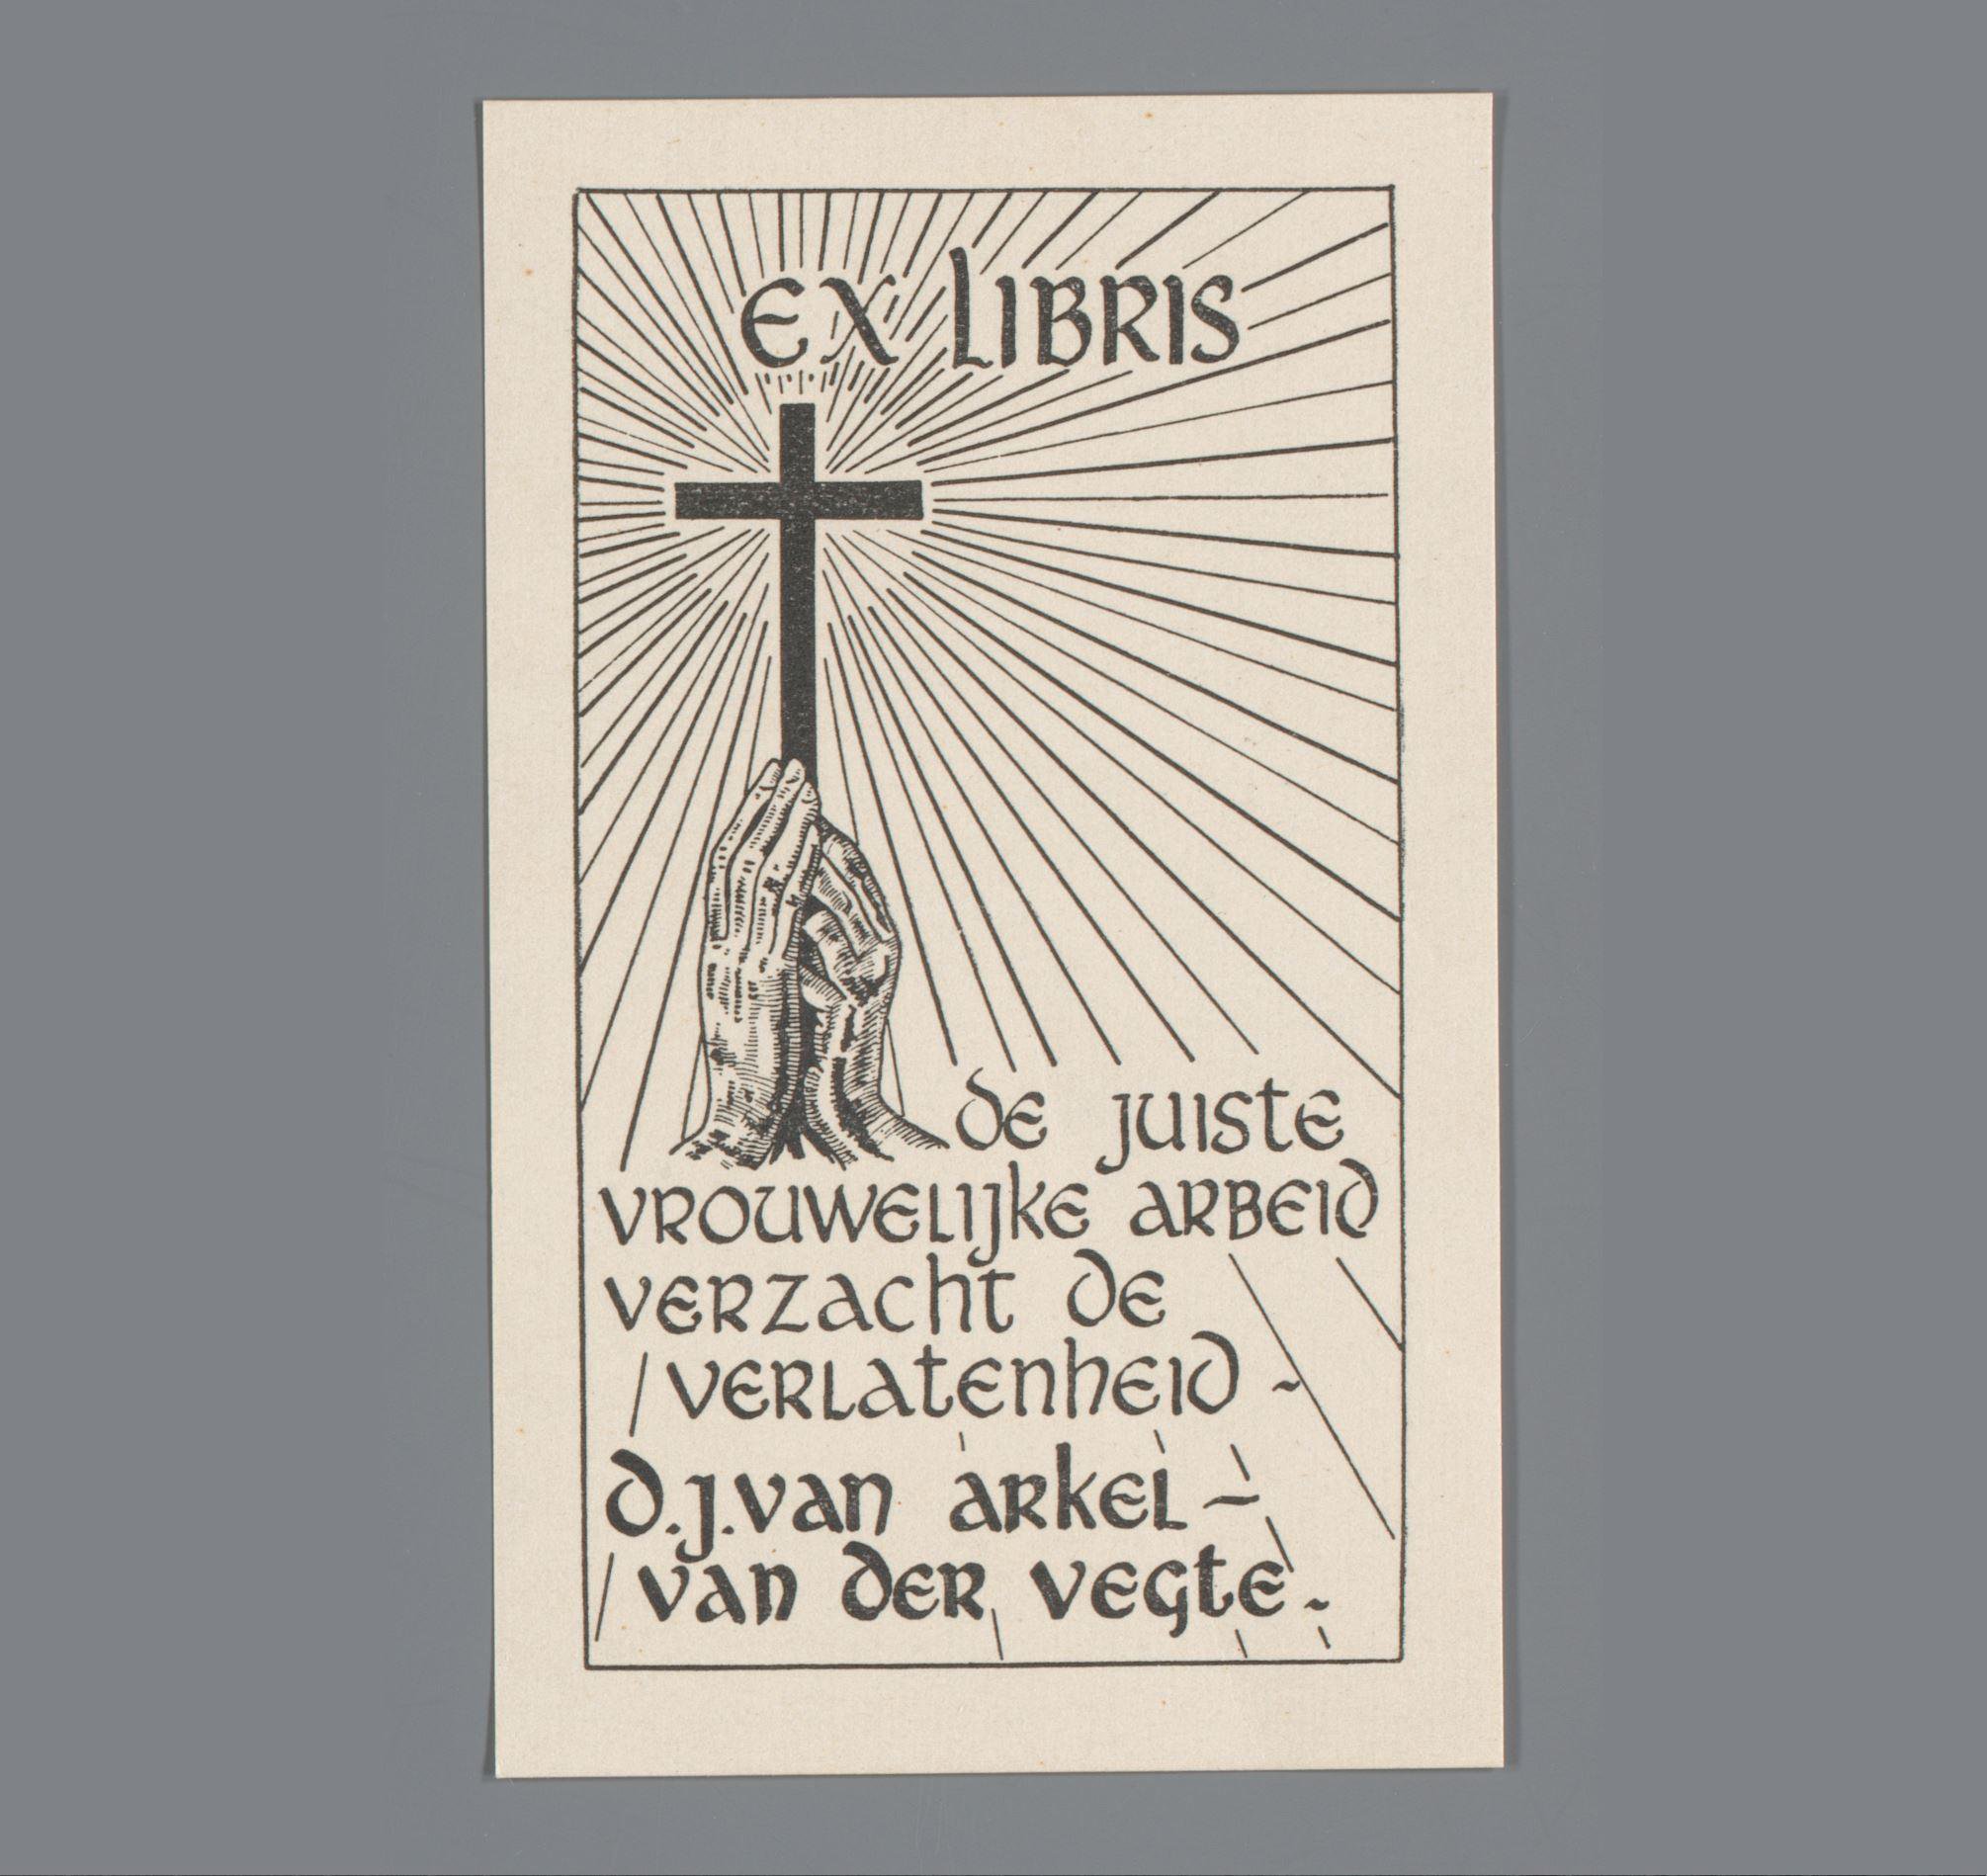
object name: bookplate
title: Ex libris van D.J. van Arkel-van der Vegte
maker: Anonymous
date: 1943-1999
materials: paper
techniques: printing block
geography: netherlands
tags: the cross ~ symbols of christ, hands folded